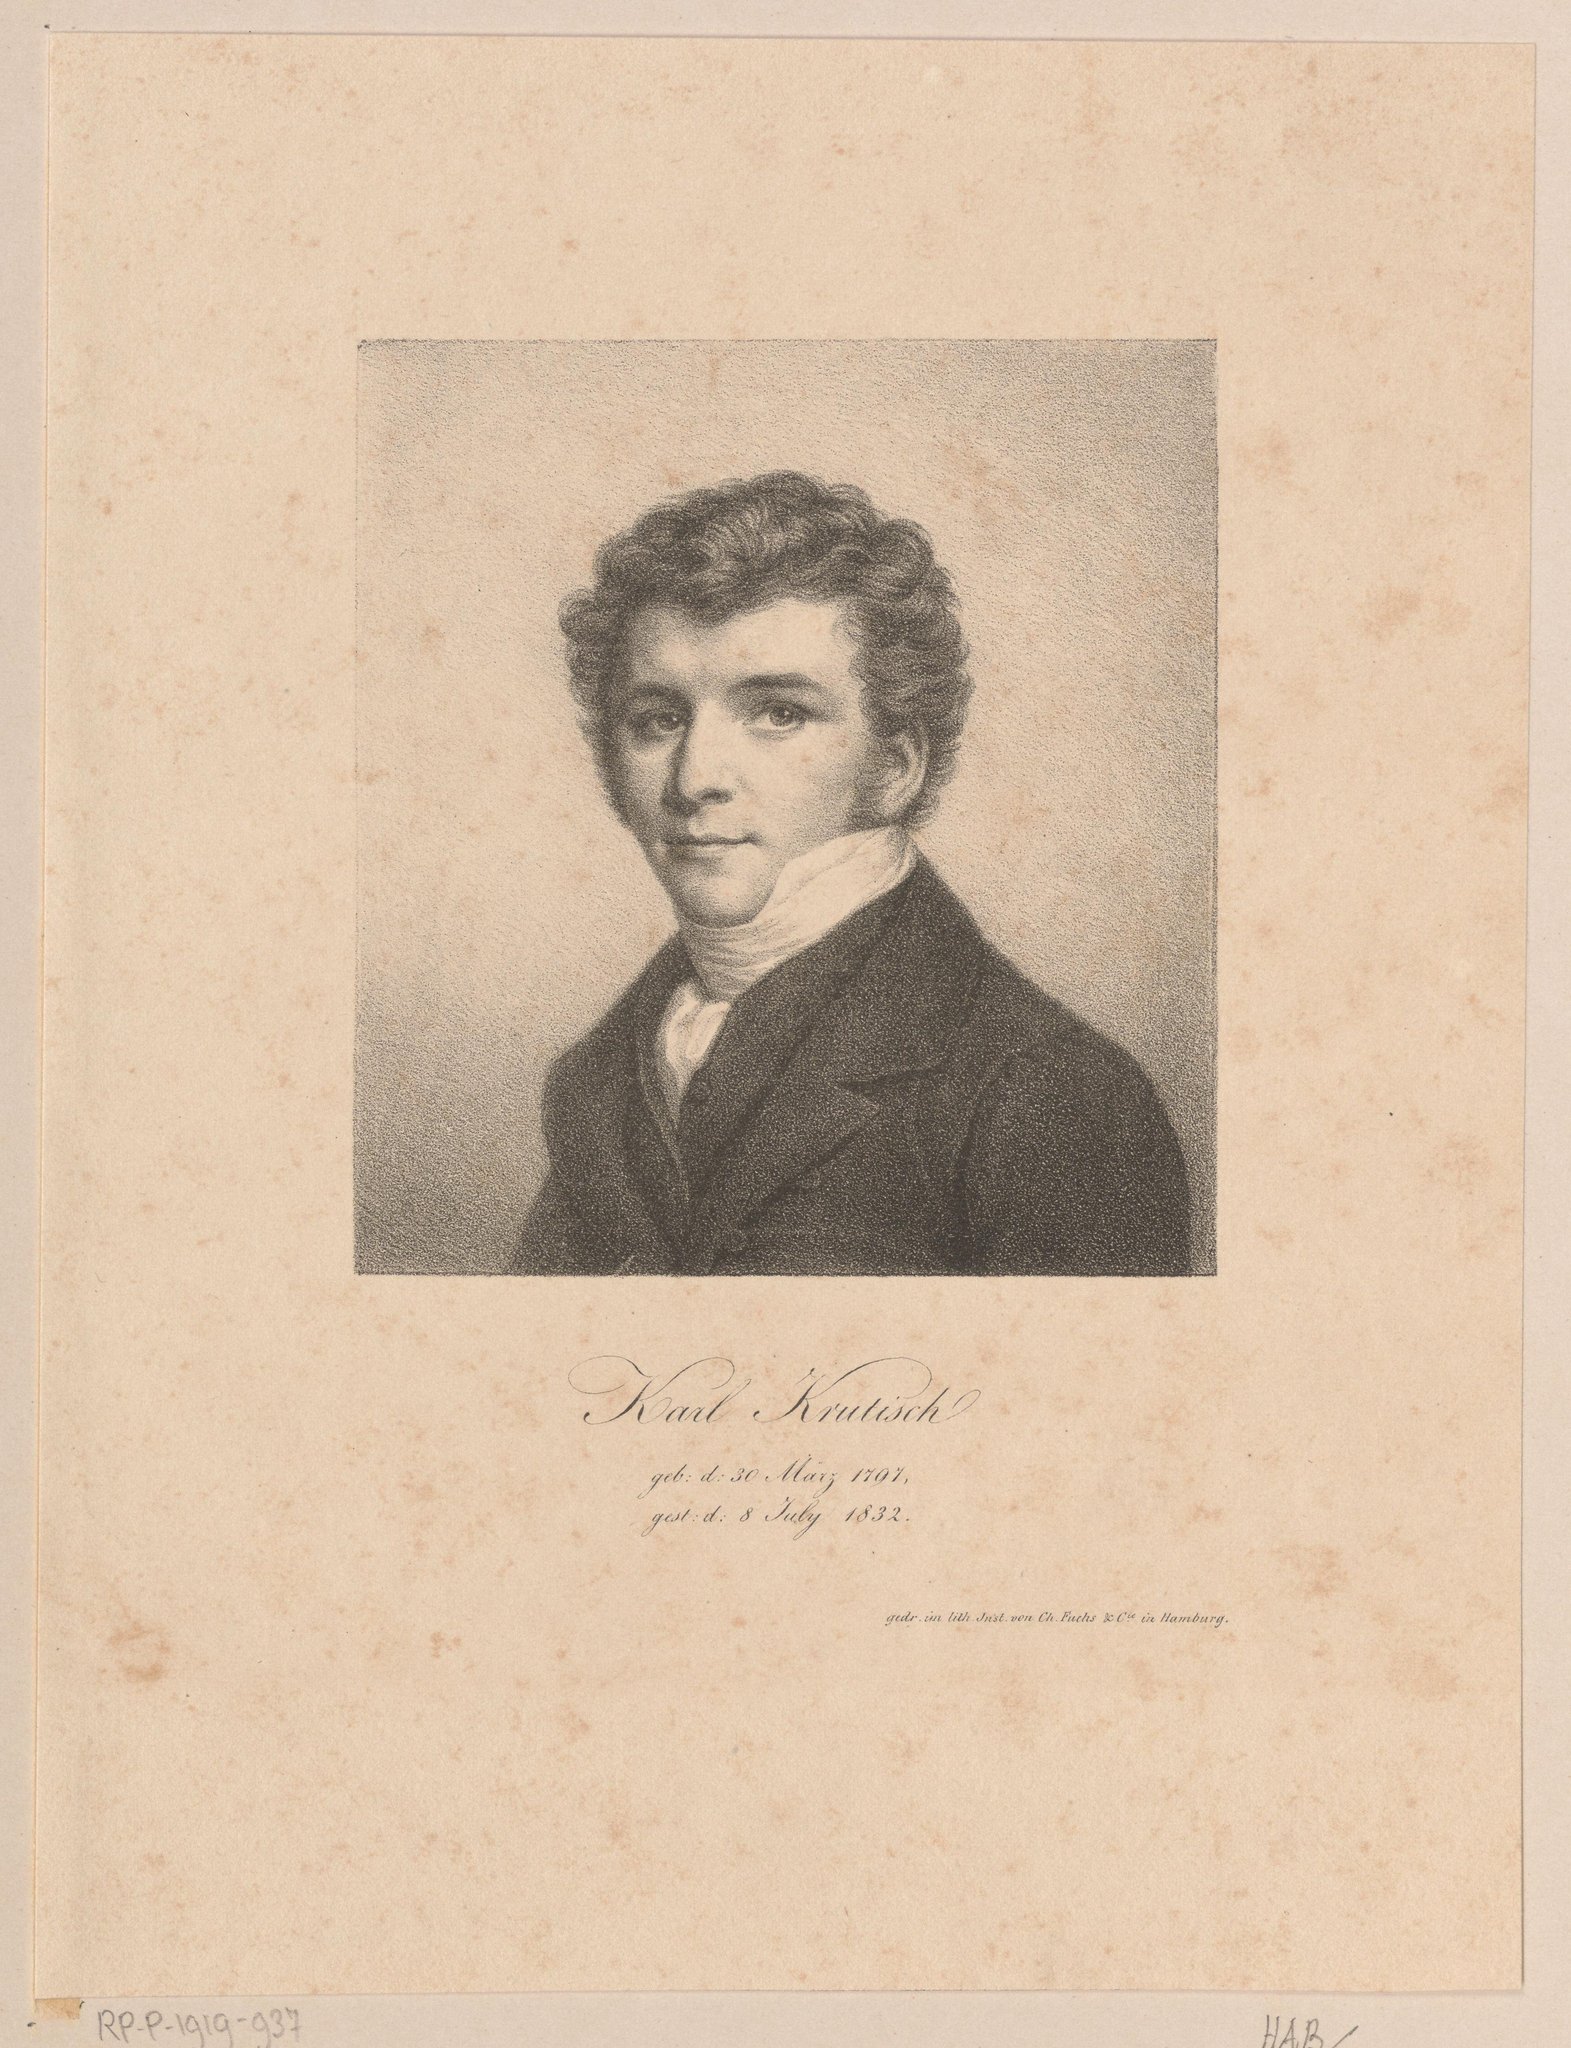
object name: print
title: Portret van Carl Friedrich Philipp Krutisch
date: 1832-1874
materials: paper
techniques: lithograph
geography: hamburg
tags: politician, historical persons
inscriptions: collector's mark: Lugt 2228